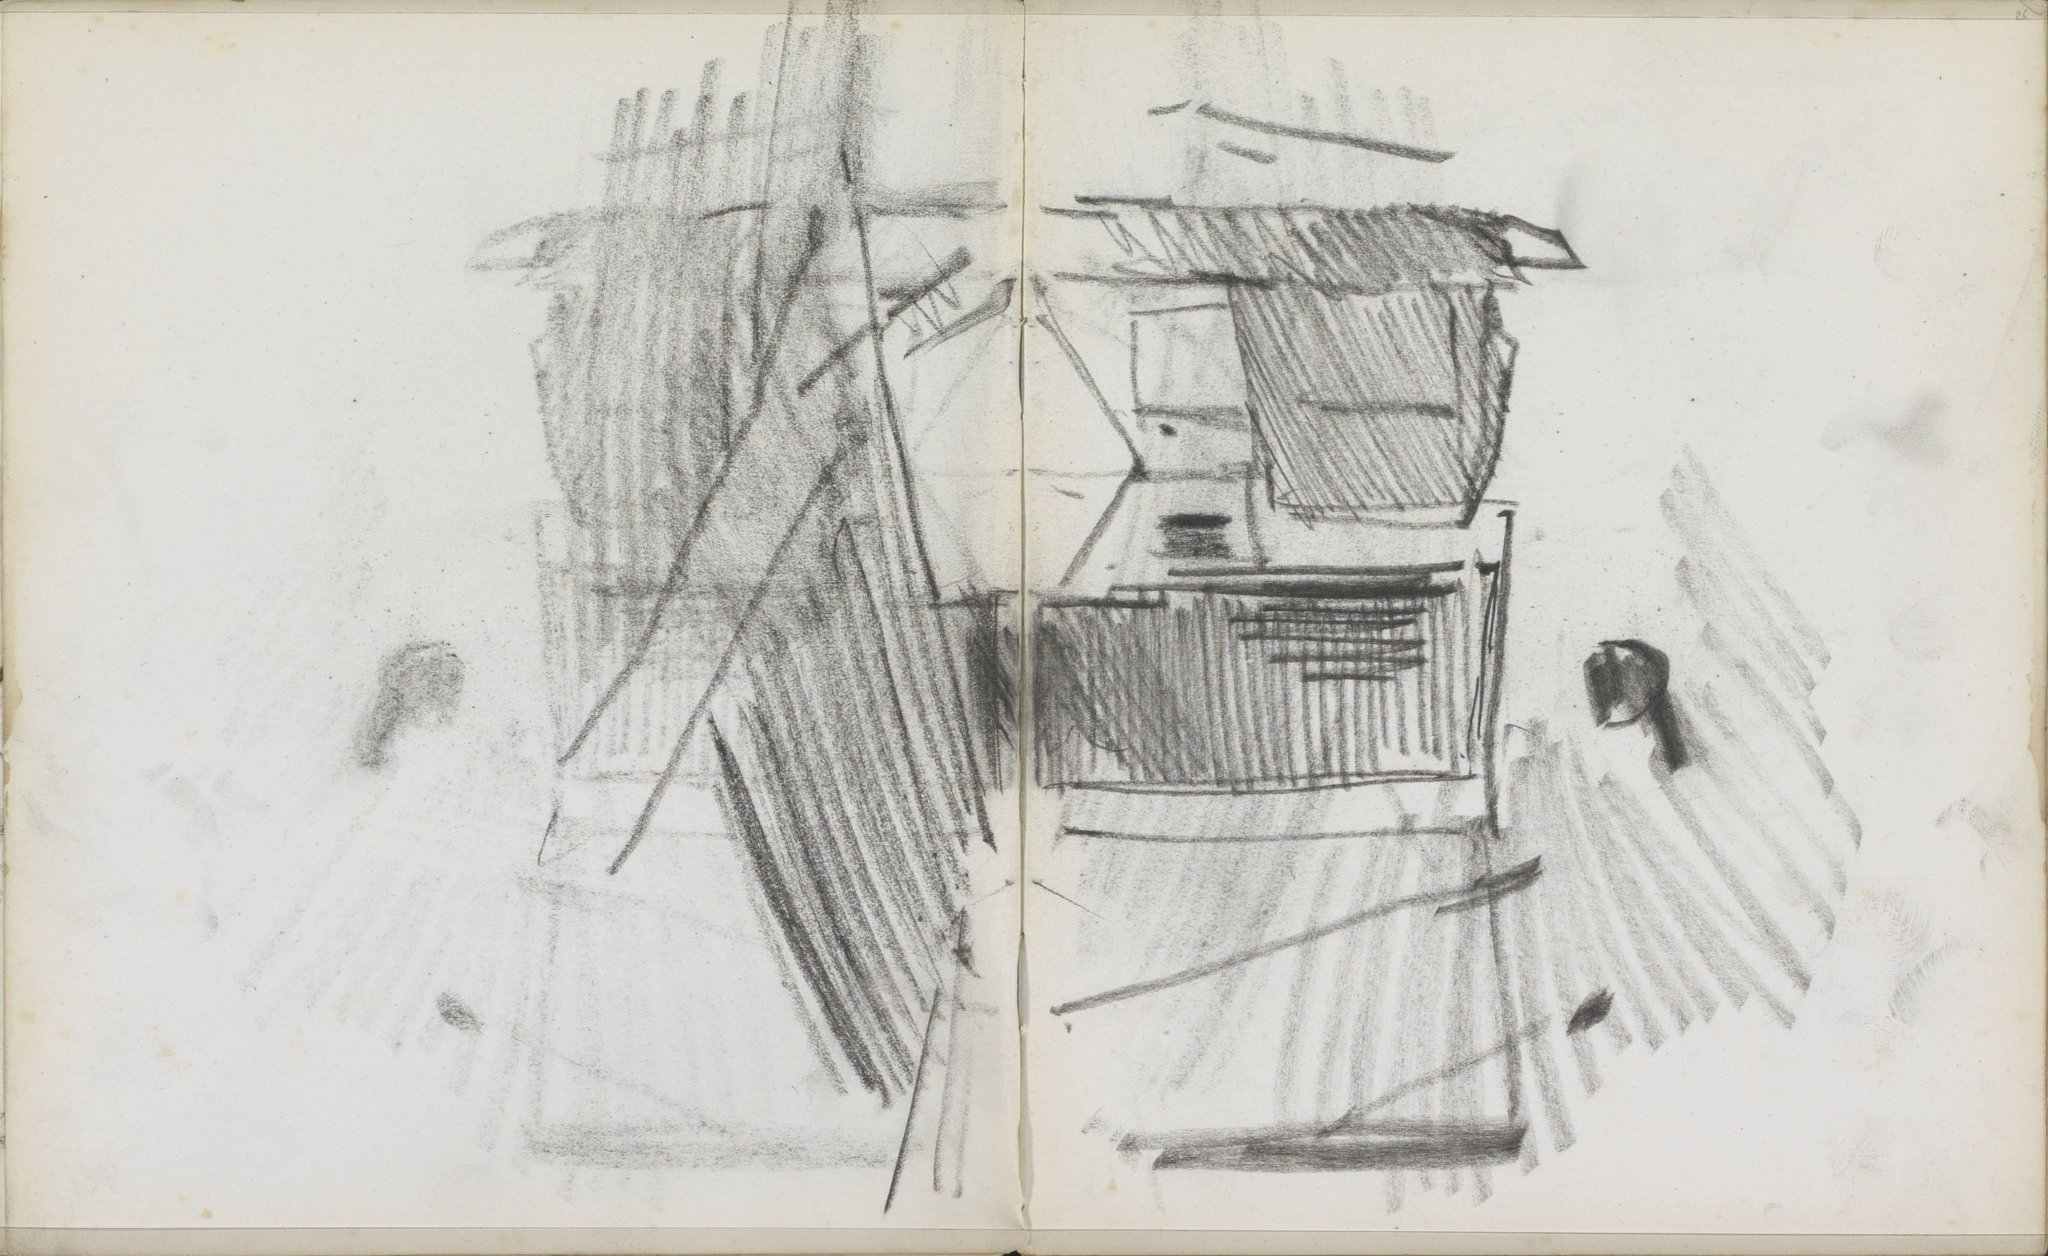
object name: sketchbook leaf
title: Bebouwing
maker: george hendrik breitner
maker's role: draughtsman, painter, print maker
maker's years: 1857-1923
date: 1880-1906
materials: chalk, paper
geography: netherlands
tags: architecture, civic architecture; edifices; dwellings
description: Pagina 25 en pagina 26 uit een schetsboek met 81 bladen.